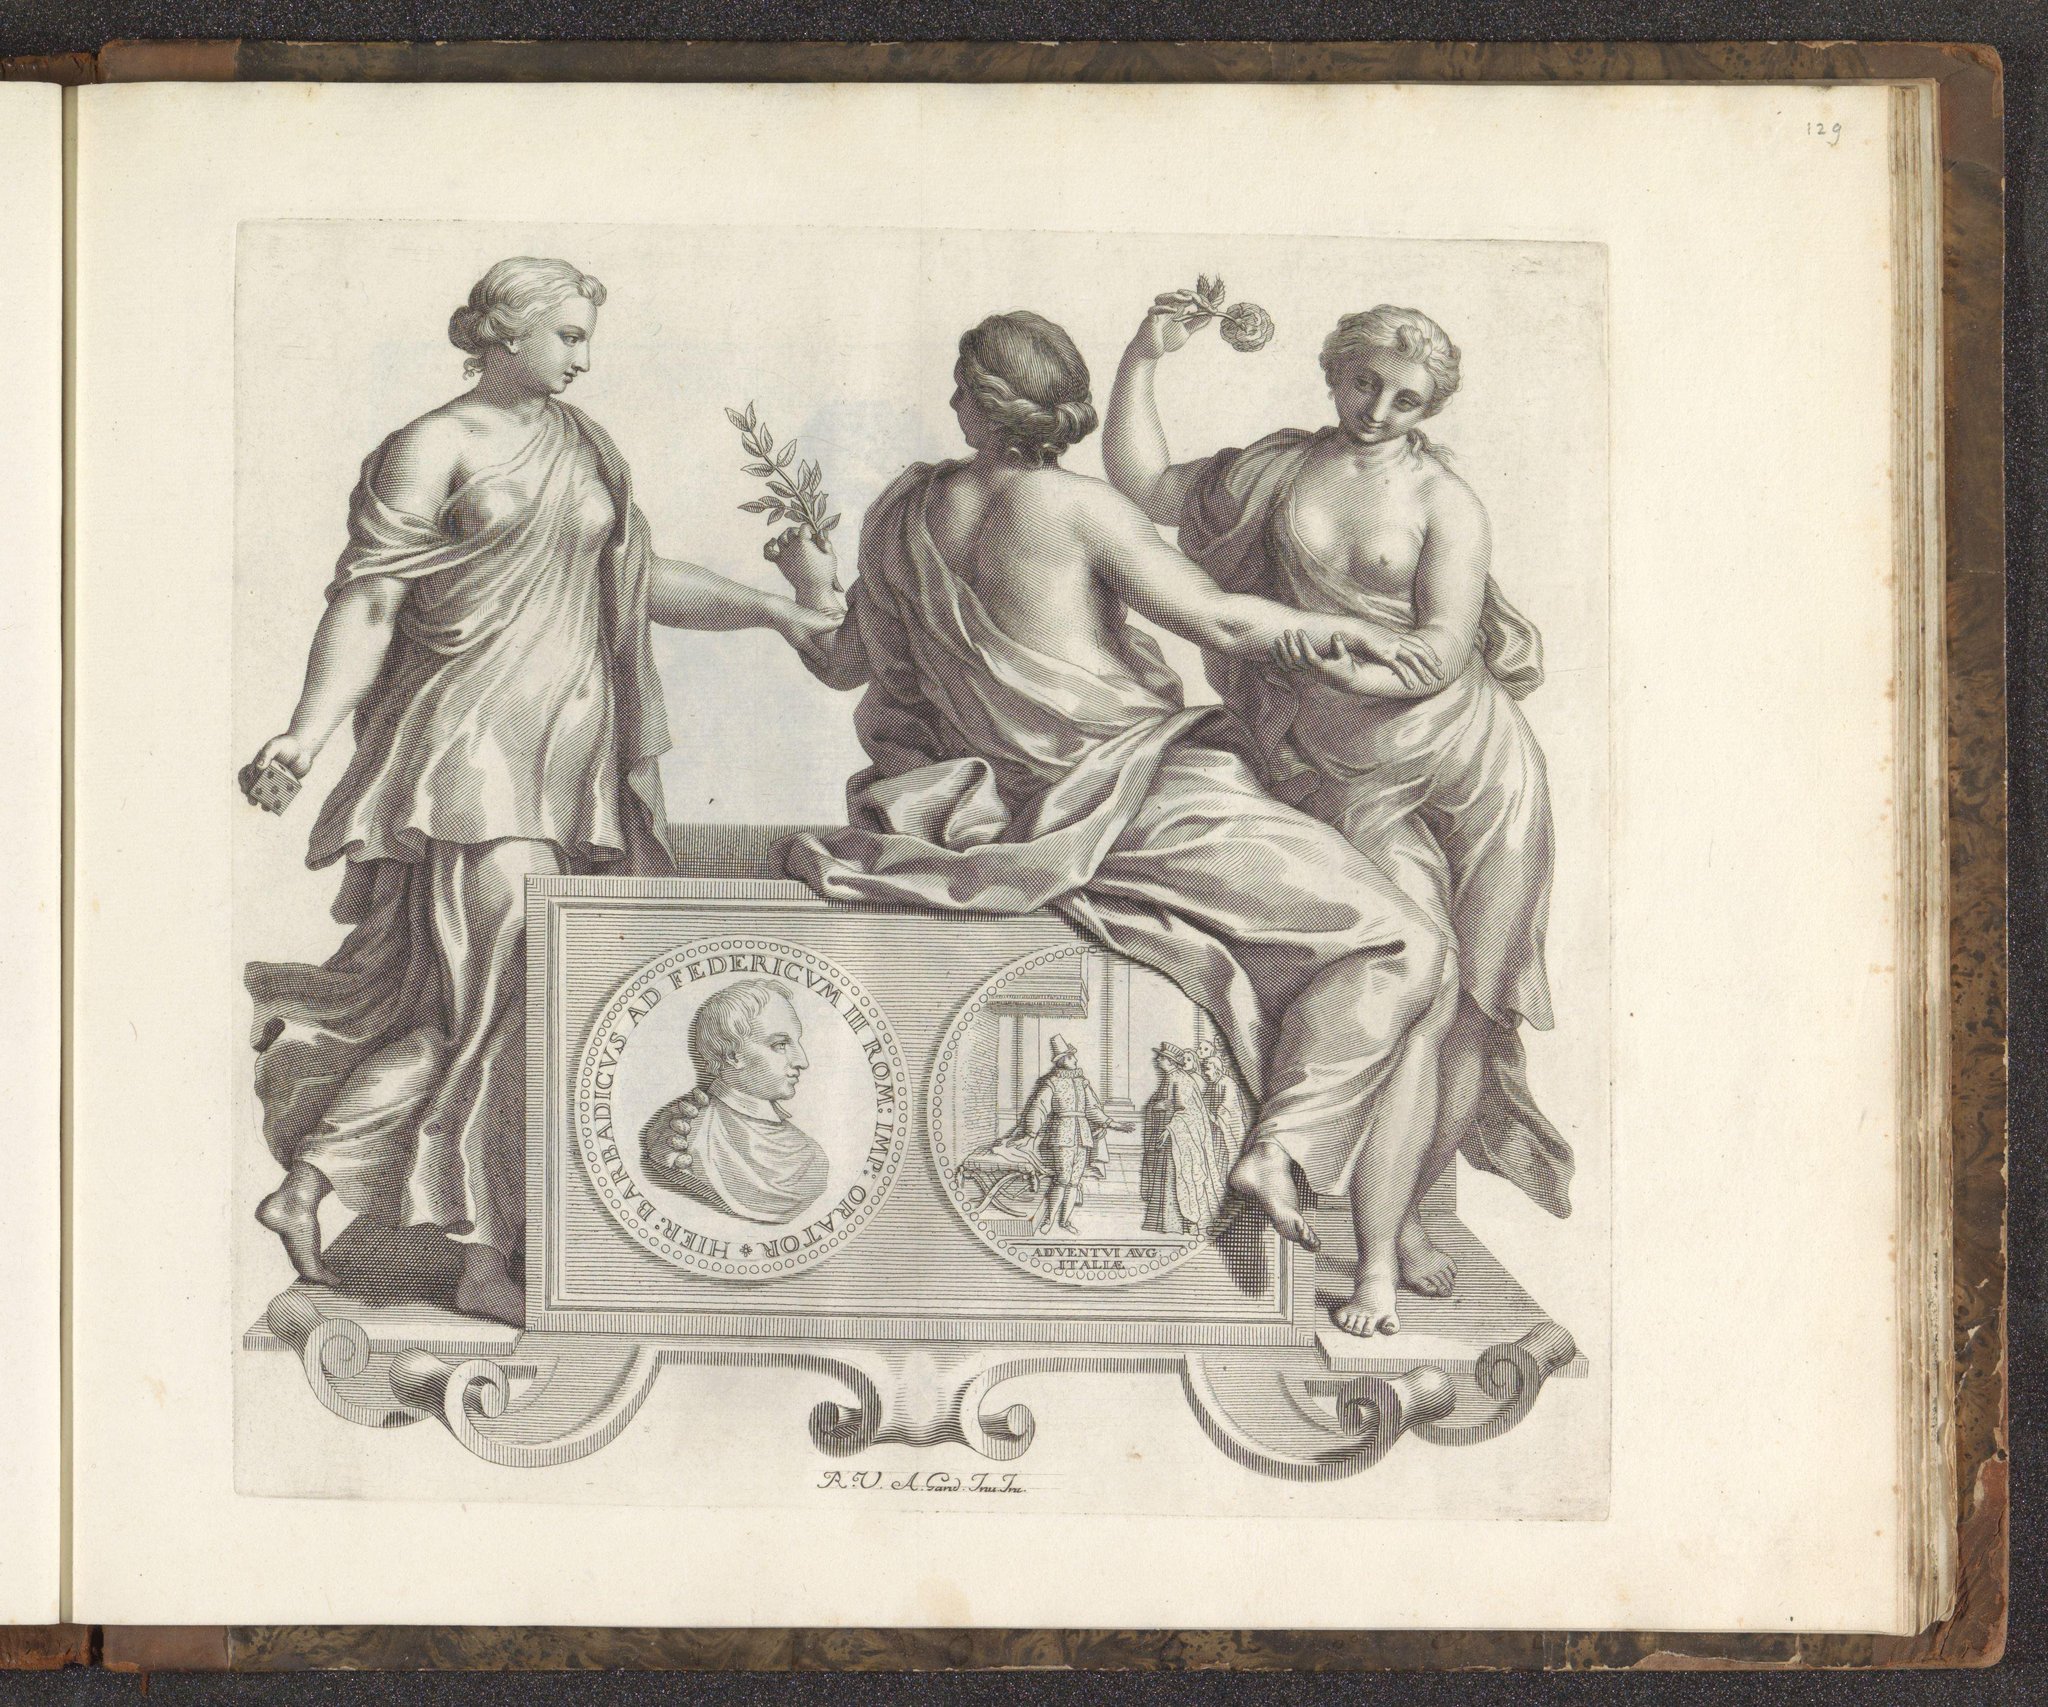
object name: album leaf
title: Numismata virorum illustrium ex Barbadica gente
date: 1673-1743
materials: paper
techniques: engraving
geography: rome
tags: audition; ruler giving audience - bb - female ruler, medal (considered as a piece of sculpture, regardless of its specific function), graces (charites), generally three in number; 'gratie' (ripa), friendship; 'amicitia' (ripa)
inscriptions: collector's mark: Lugt 2228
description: Voetstuk in de vorm van een cartouche. Daarop een medaillon met op de voorzijde het portret van Girolamo Barbarigo. Op de achterkant wordt een Venetiaanse afvaardiging ontvangen door keizer Frederik III, staande onder een baldakijn. Rond het voetstuk de personificatie van de Vriendschap, uitgebeeld met de Drie Gratiën. Als groep staan zij zo opgesteld dat beide buitenste figuren in het gezicht te zien zijn en de middelste juist niet. Hun attributen zijn een dobbelsteen, mirtetak en roos. De prent maakt deel uit van een album.